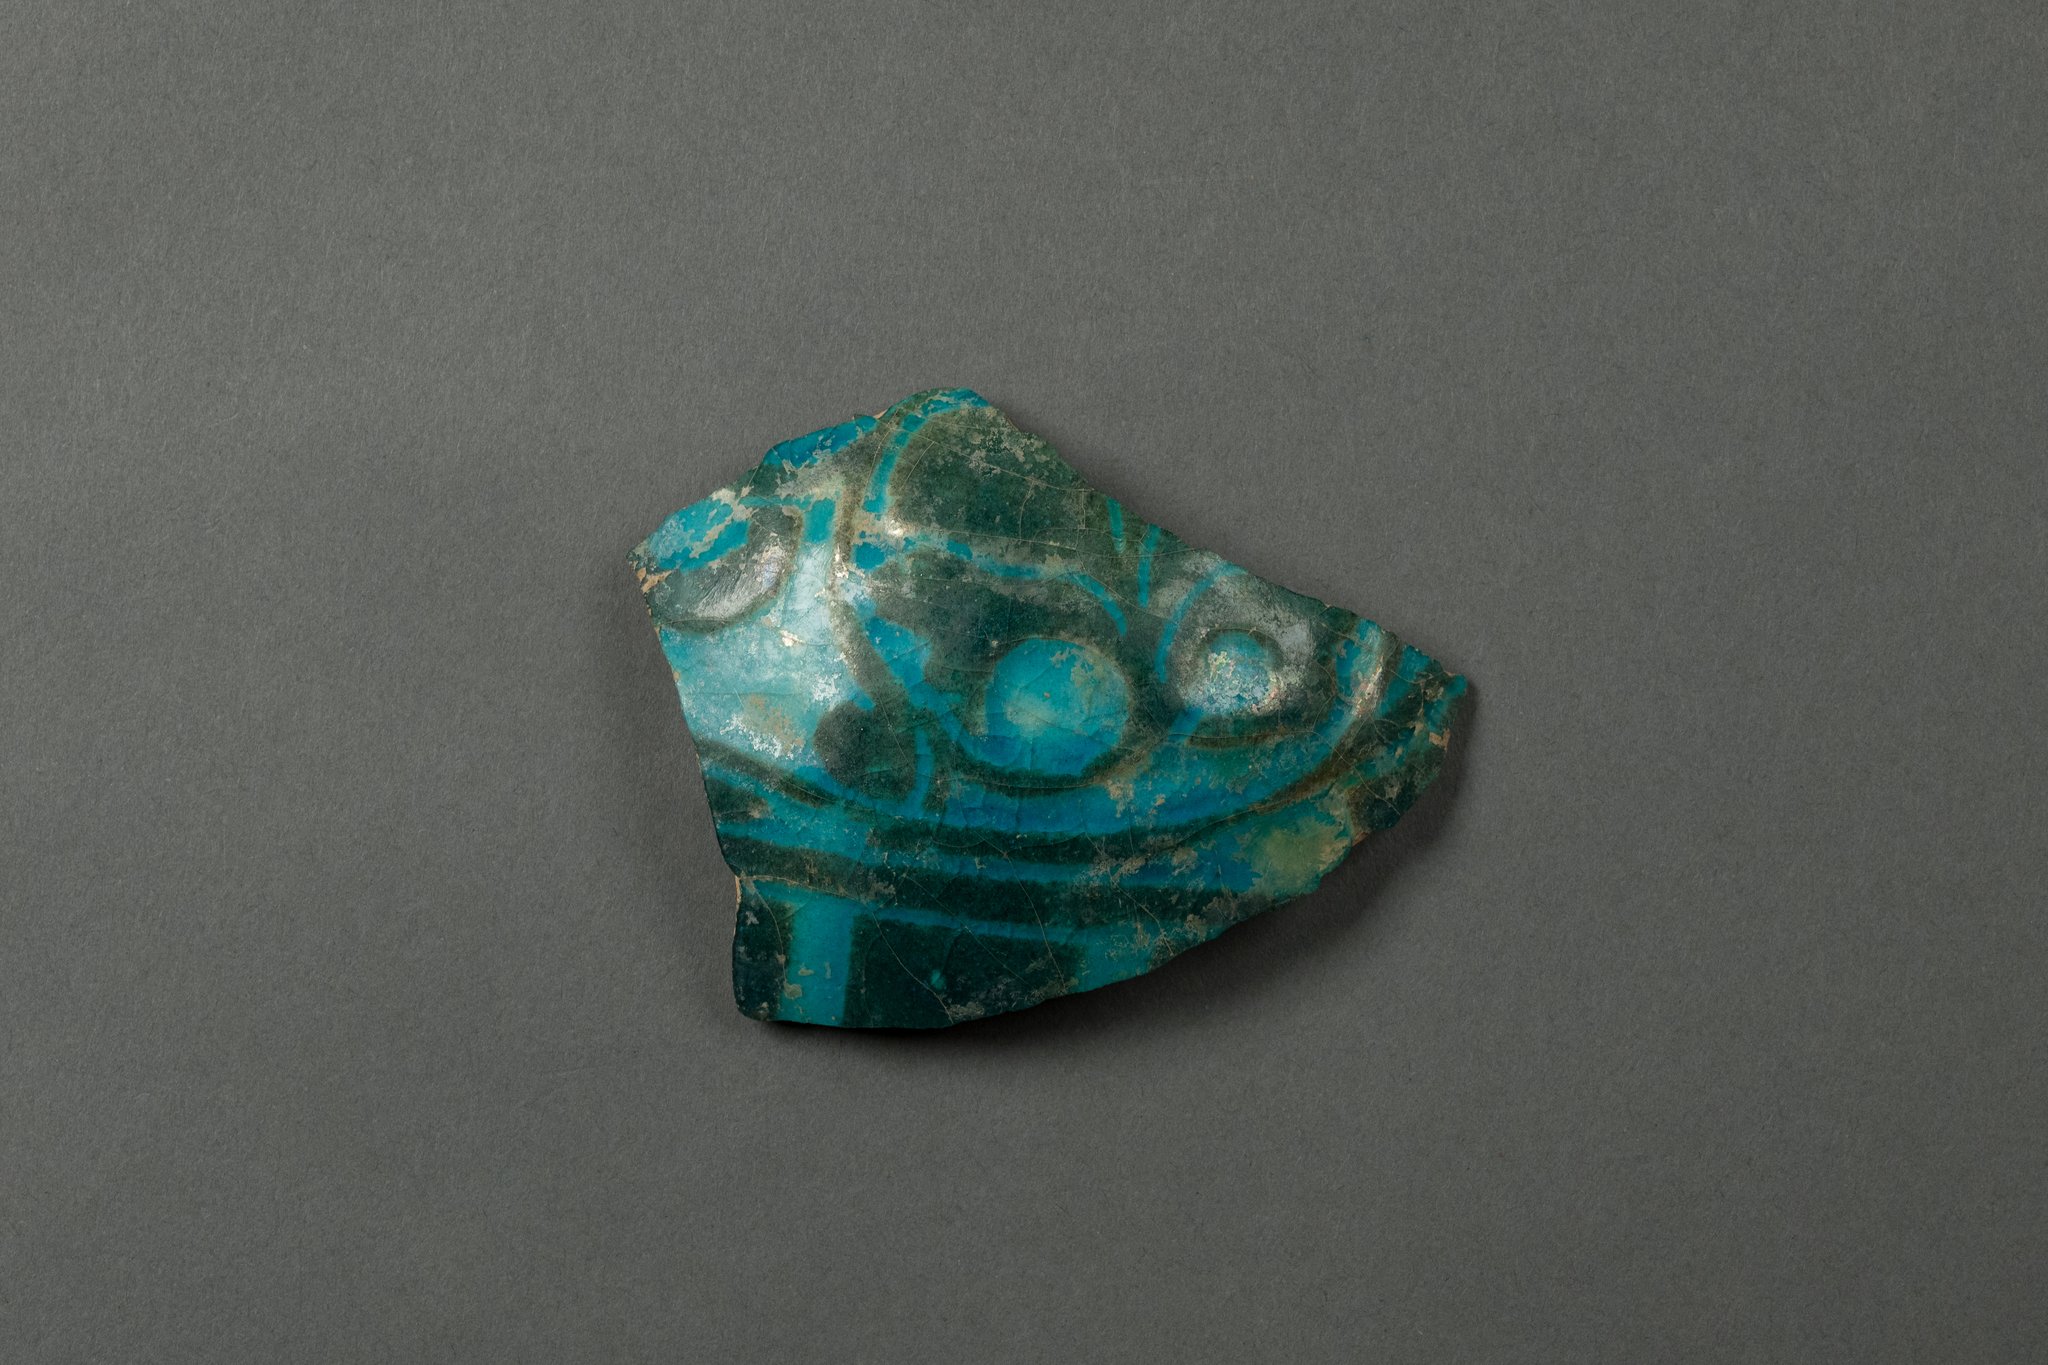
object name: fragment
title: Fragment of Ewer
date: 701-1300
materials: earthenware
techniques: glazing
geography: iran